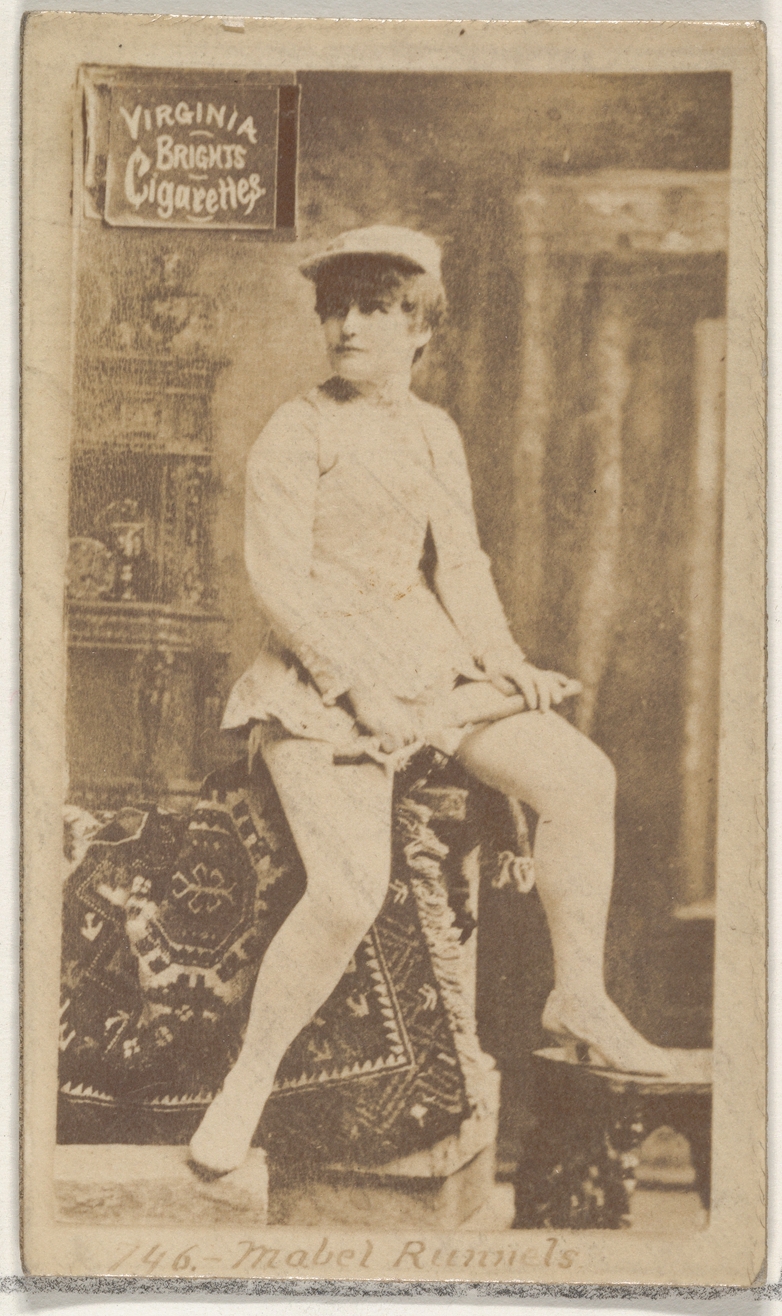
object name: photograph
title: Card 746, Mabel Runnels, from the Actors and Actresses series (N45, Type 2) for Virginia Brights Cigarettes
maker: allen & ginter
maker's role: publisher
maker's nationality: american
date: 1888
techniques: albumen silver print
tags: portraits,women,actresses